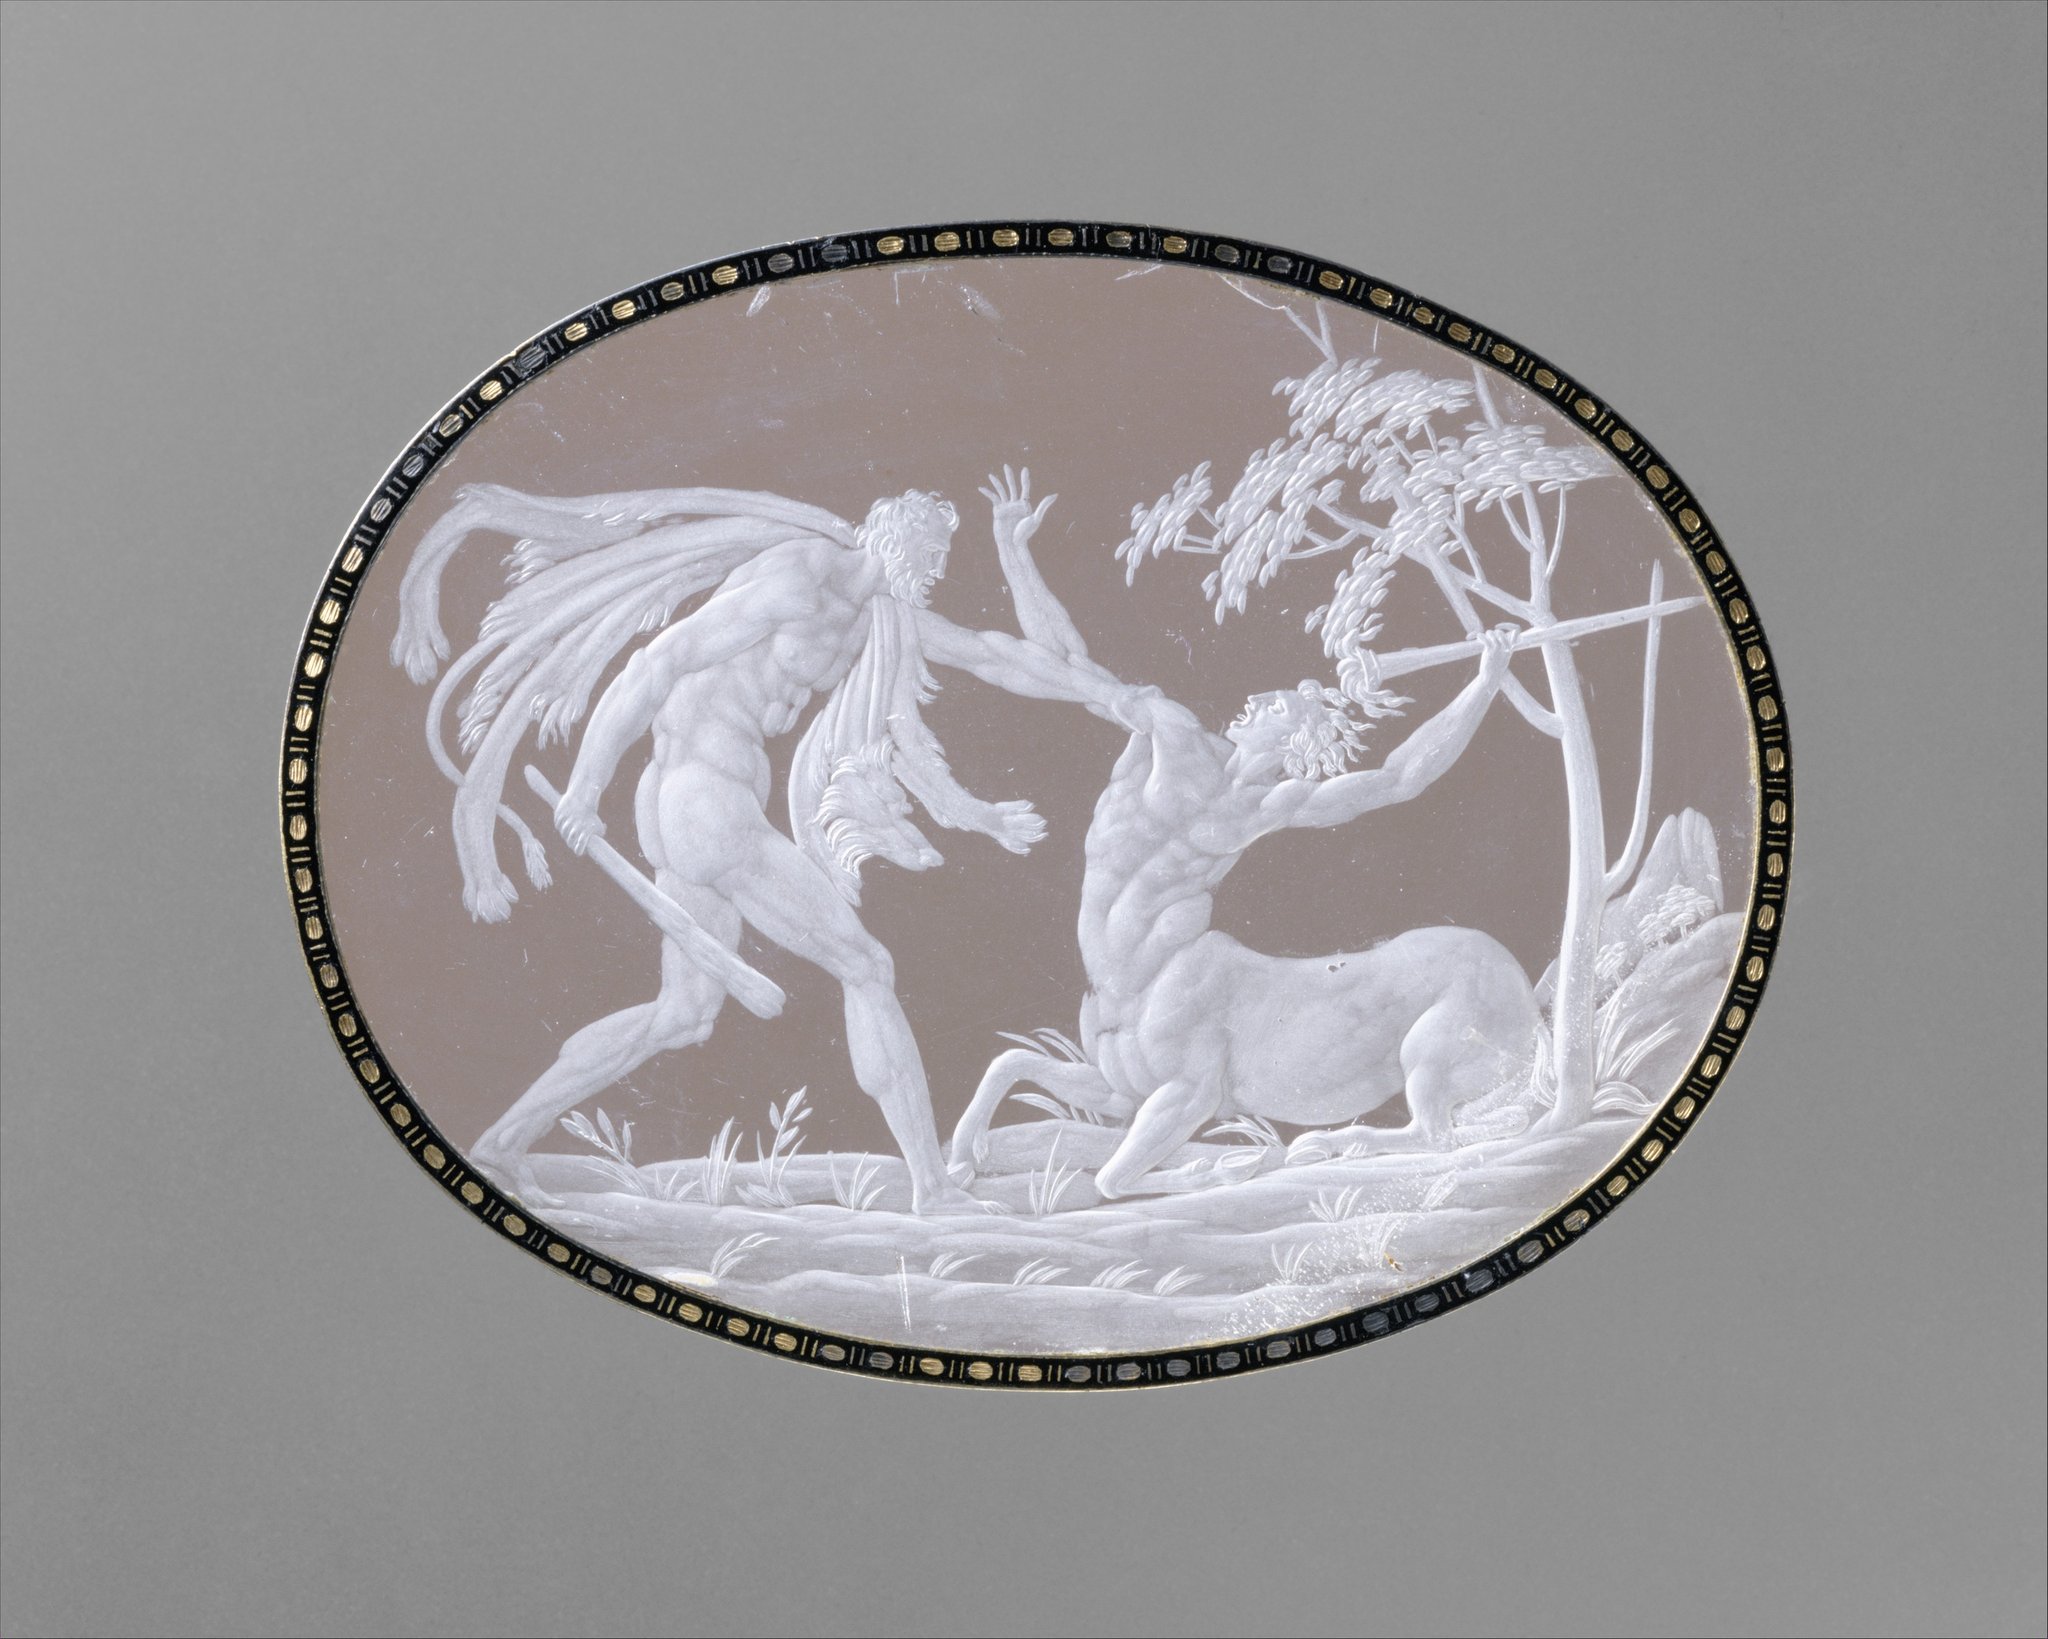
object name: plaque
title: Hercules and Nessus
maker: annibale fontana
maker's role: artist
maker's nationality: italian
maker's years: 1540-1587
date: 1584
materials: enamel, gold, quartz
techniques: enamel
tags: men,hercules,centaurs